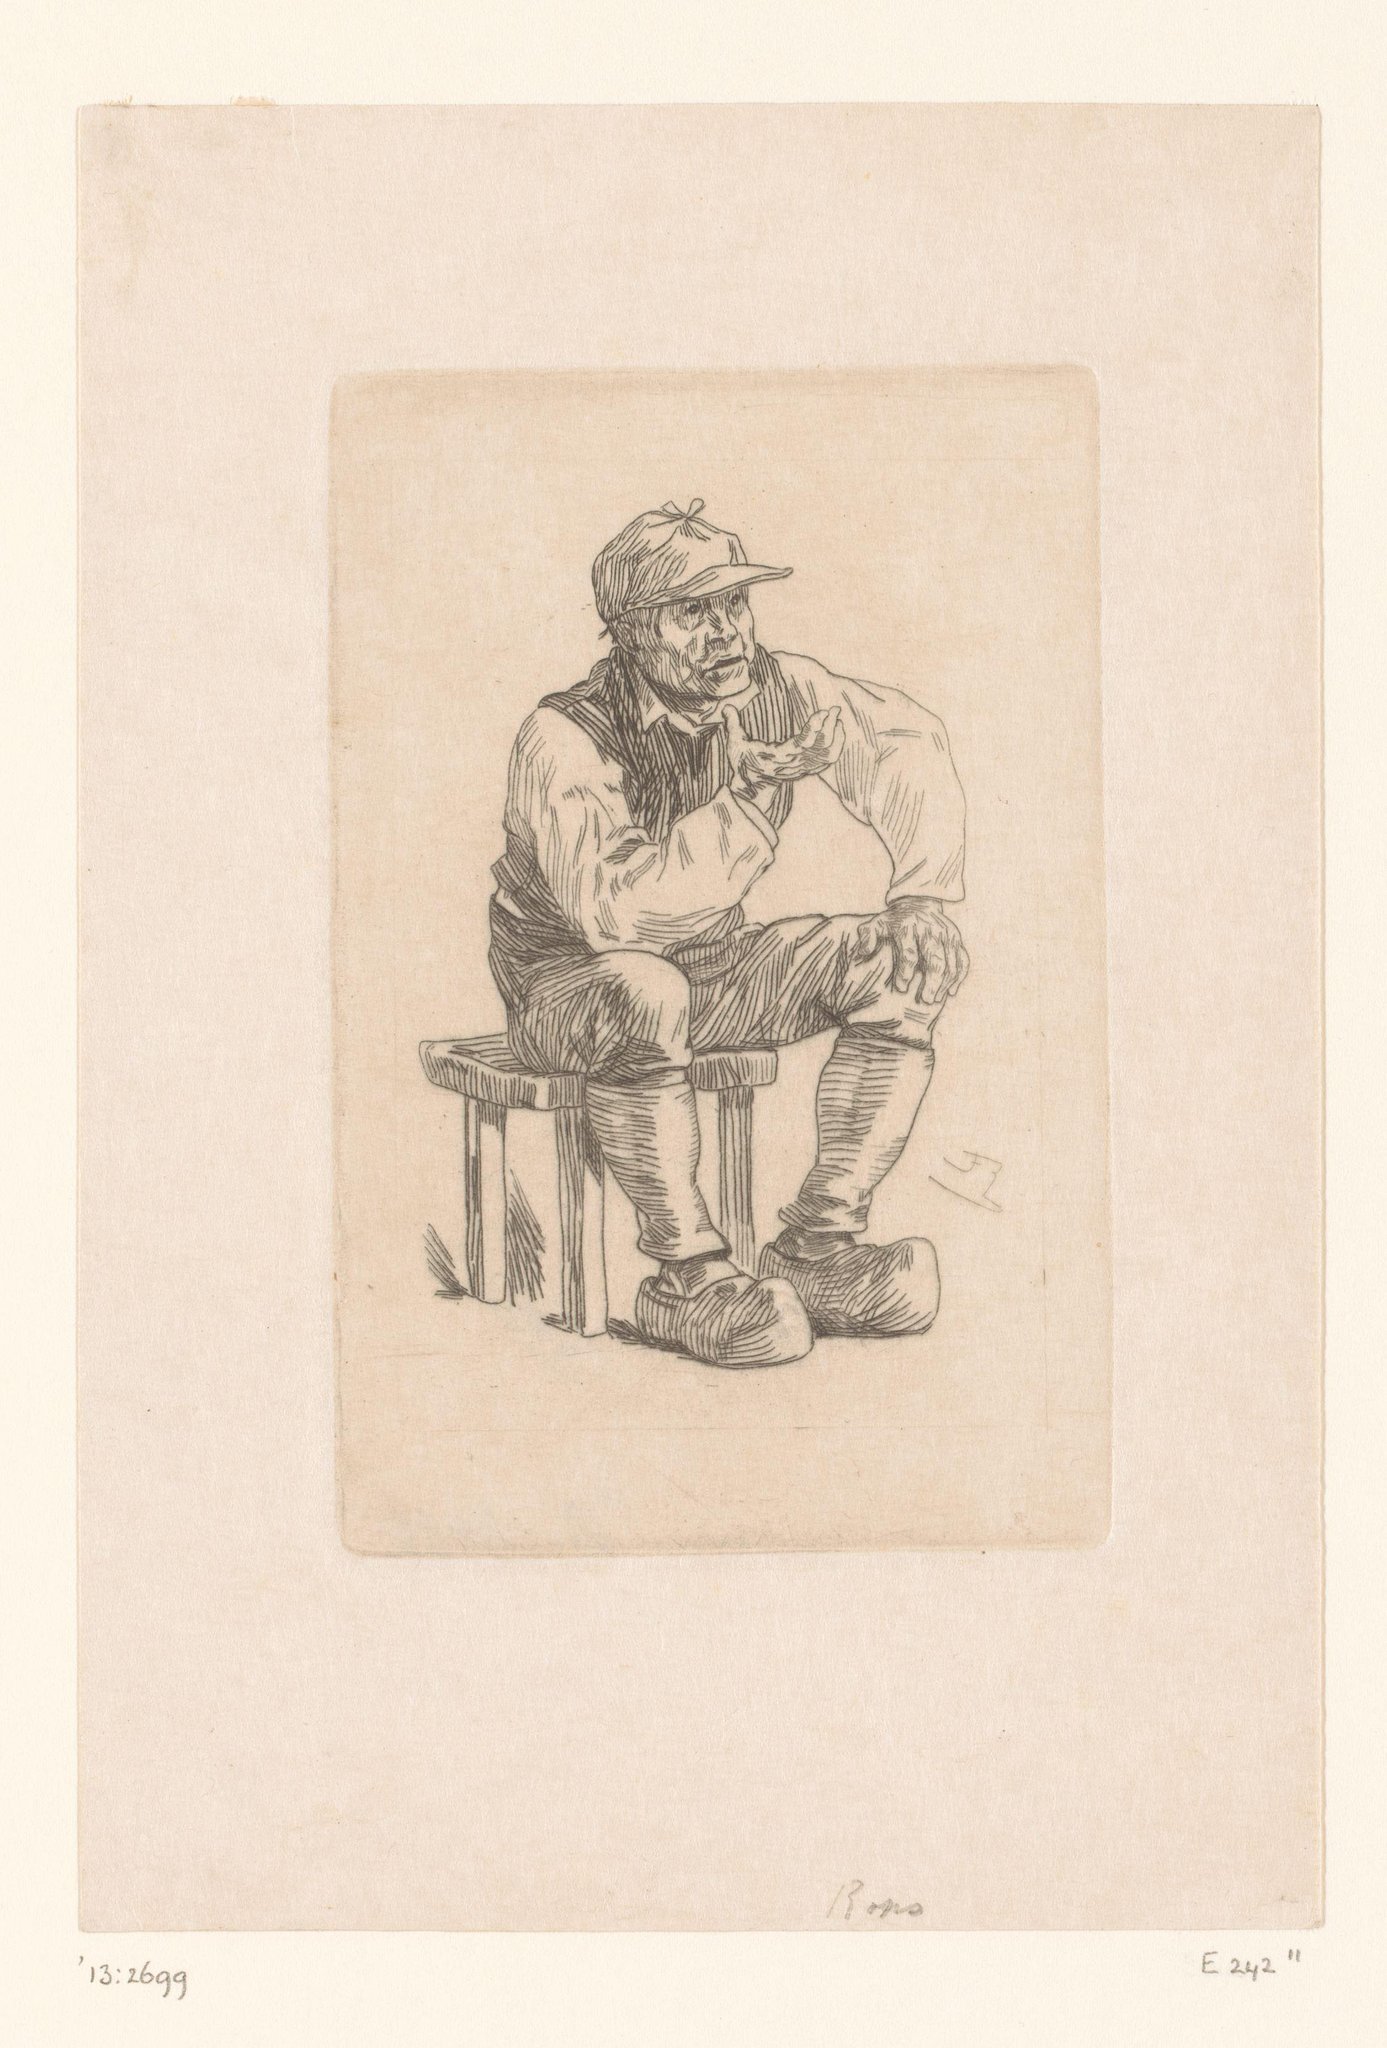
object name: print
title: Man op klompen op een kruk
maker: félicien rops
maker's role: draughtsman, print maker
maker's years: 1833-1898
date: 1875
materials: paper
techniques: etching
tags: old man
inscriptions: collector's mark: Lugt 2228